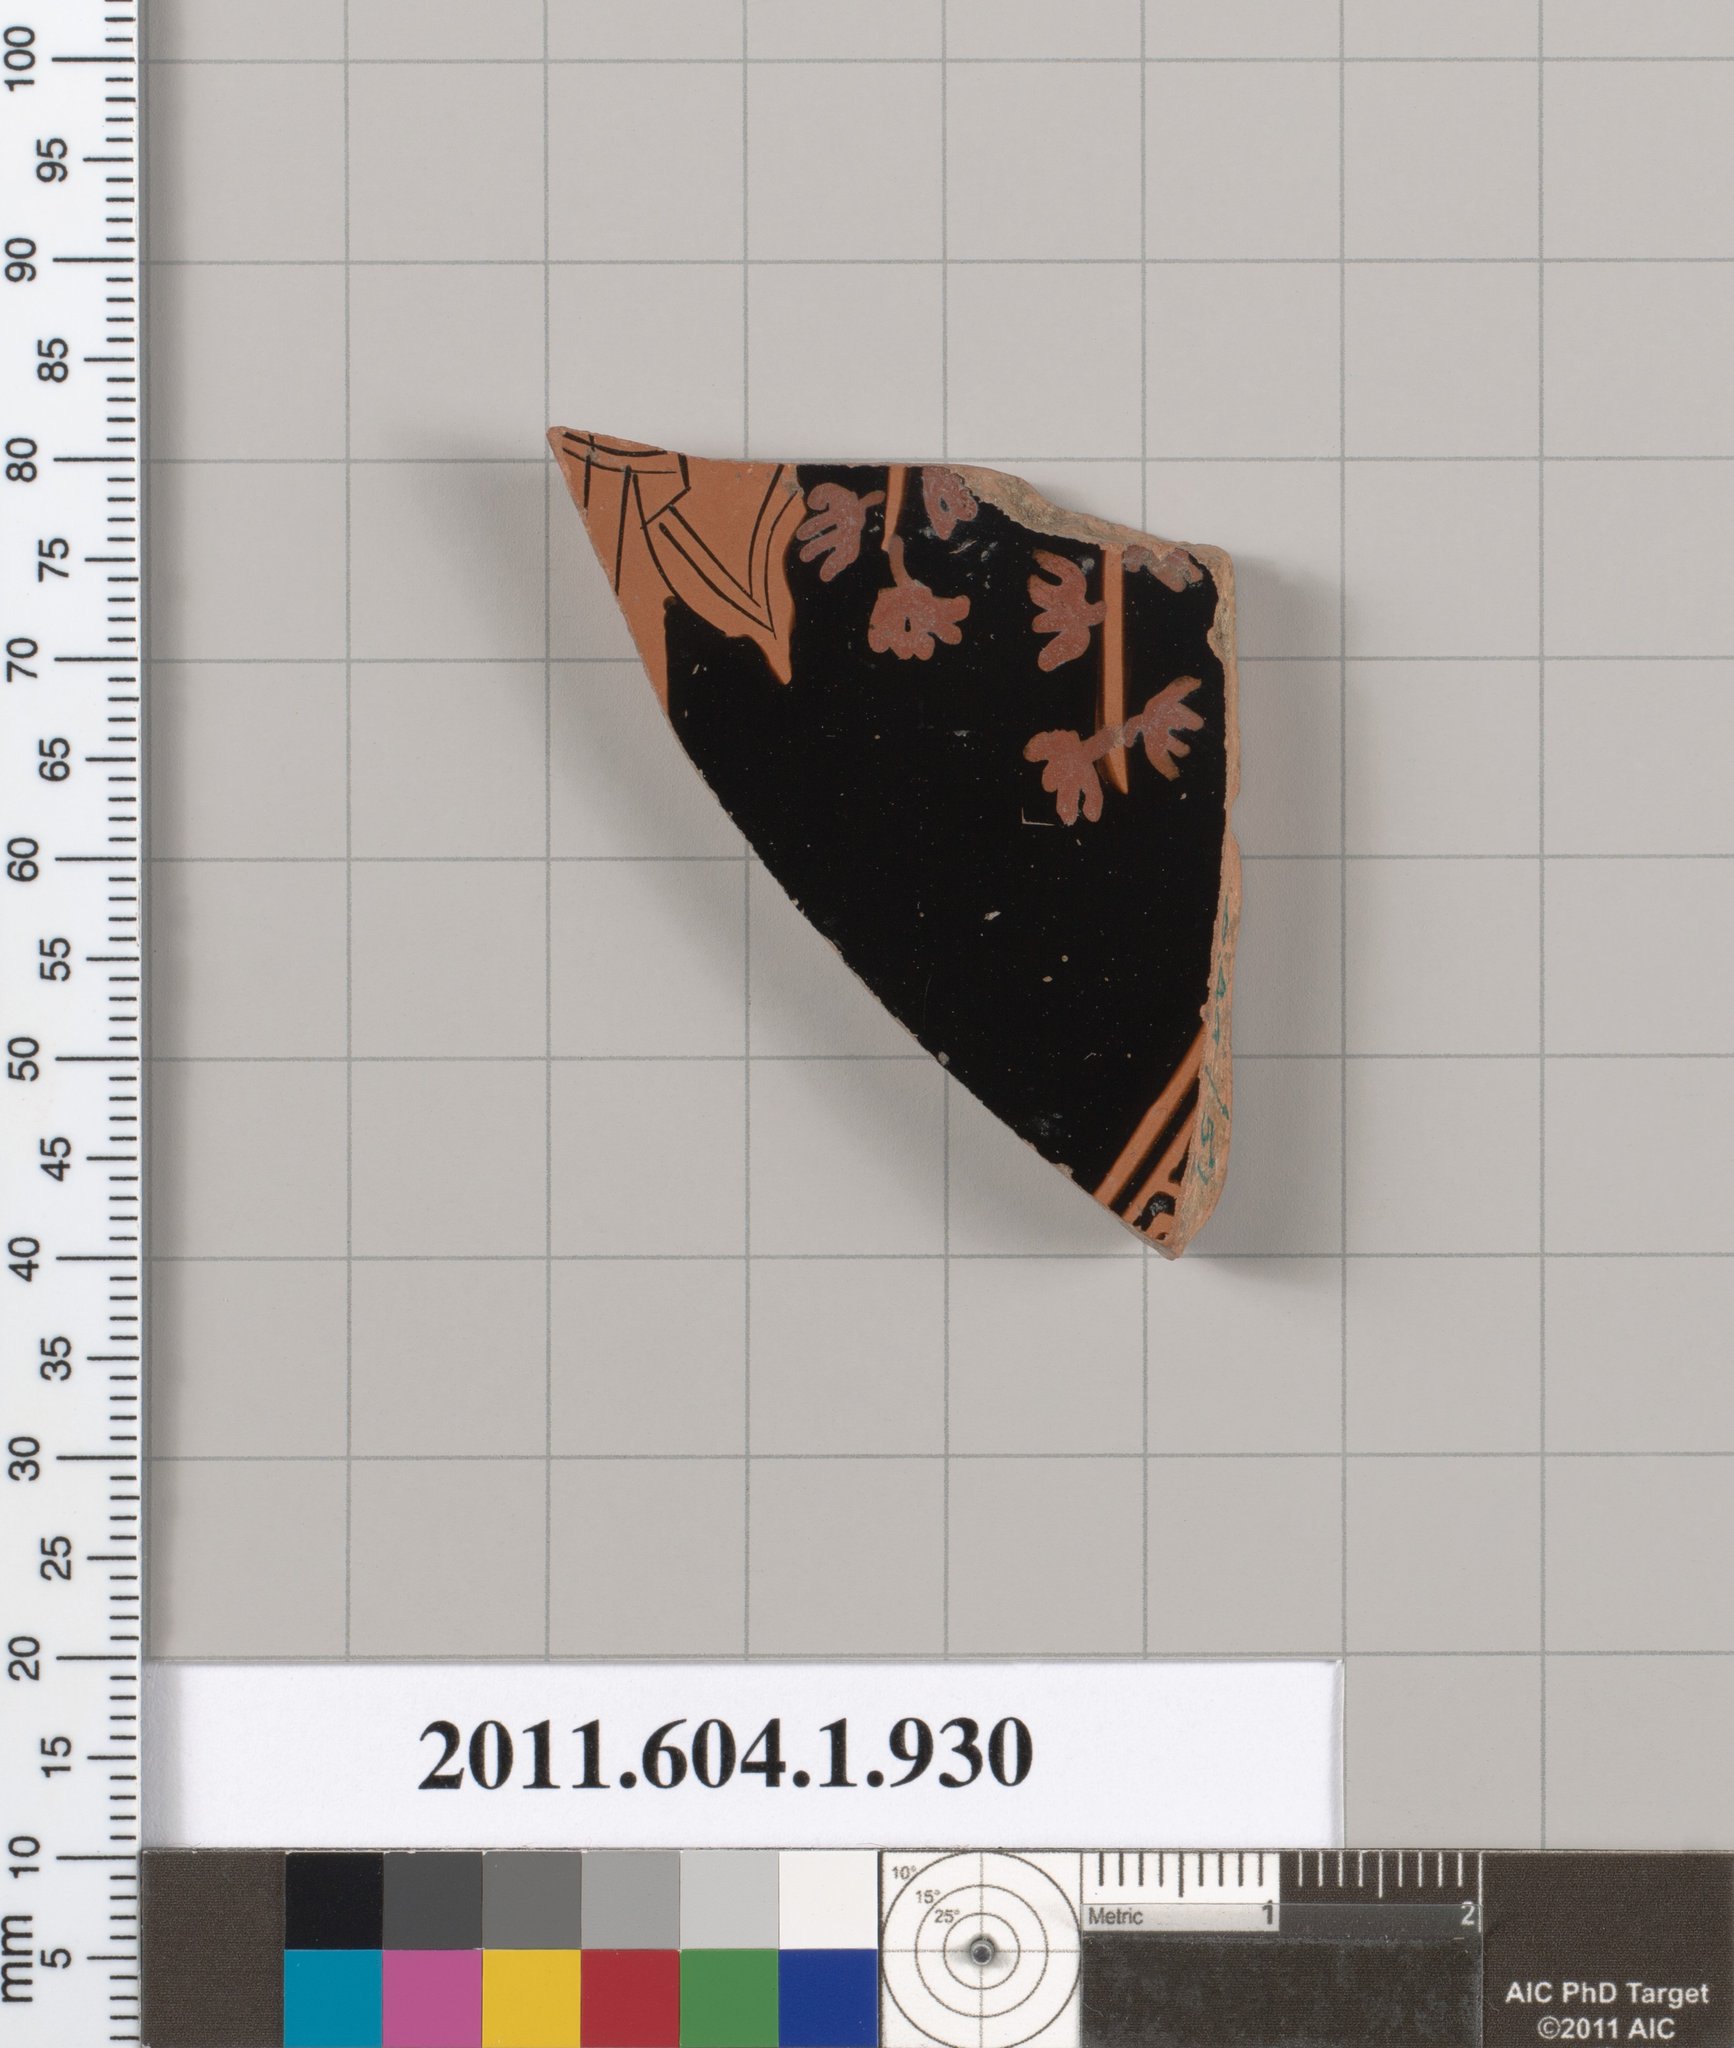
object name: kylix fragment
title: Terracotta fragment of a kylix (drinking cup)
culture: greek, attic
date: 490-480 BCE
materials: terracotta